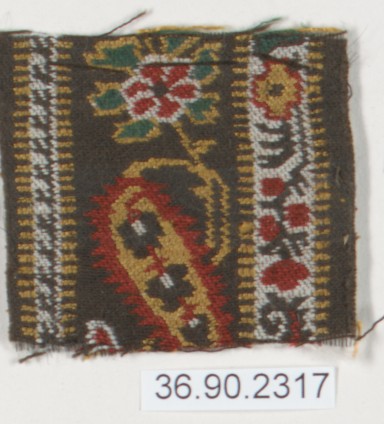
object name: border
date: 1801-1900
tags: flowers